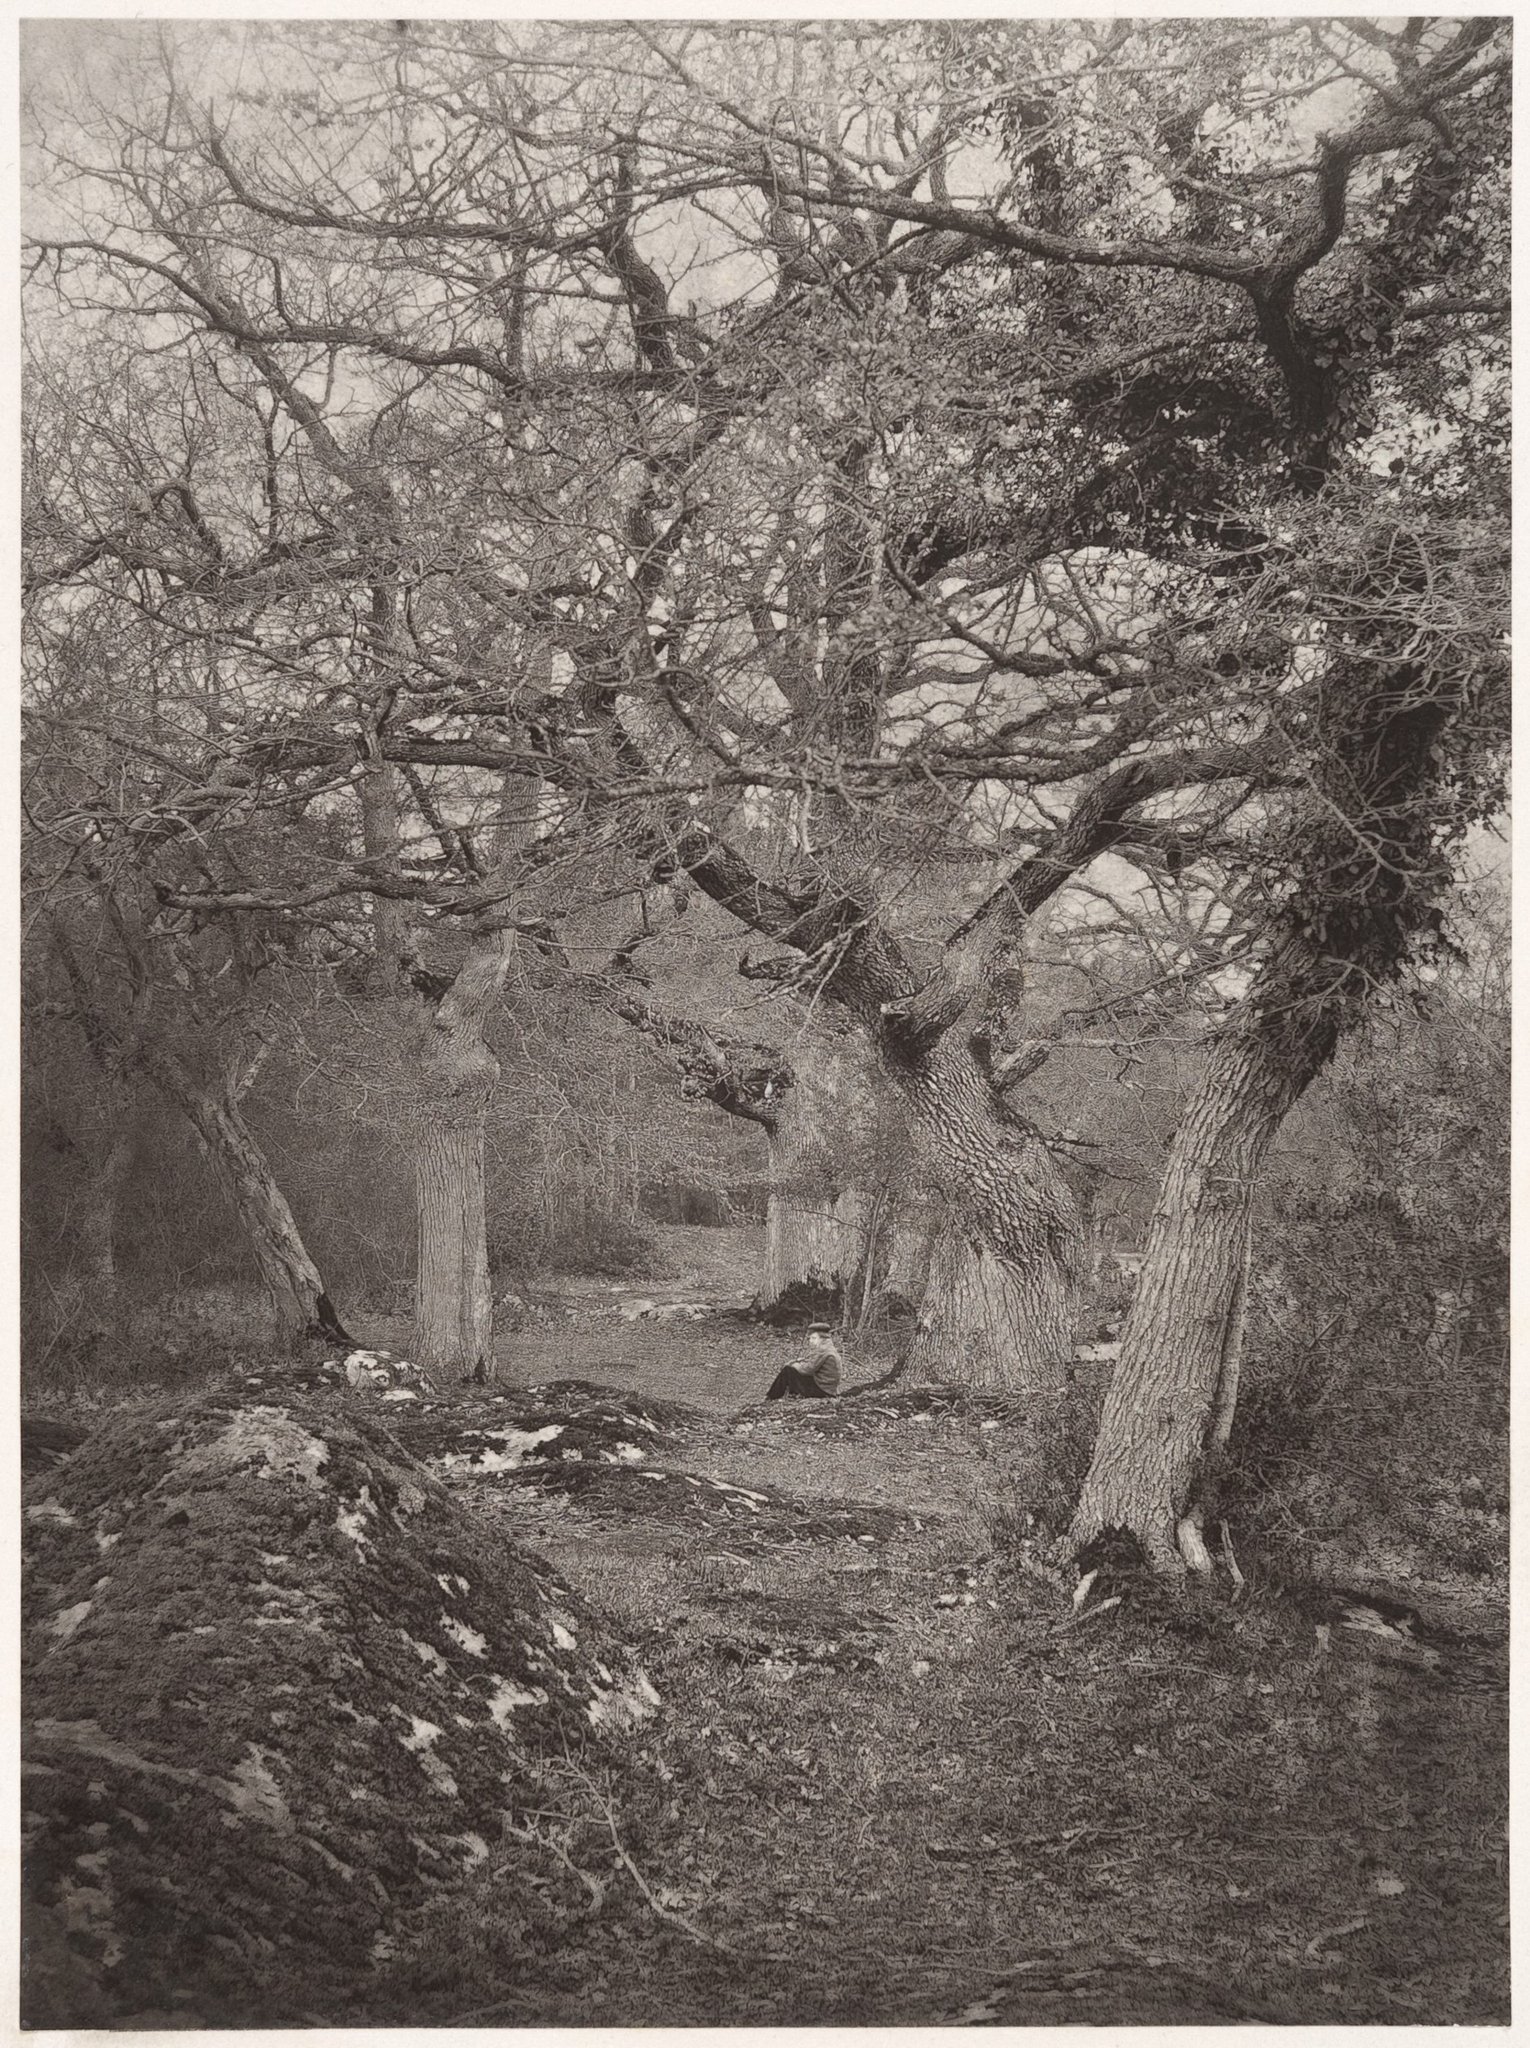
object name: photograph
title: Forêt de Fontainebleau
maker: william harrison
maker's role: artist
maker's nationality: british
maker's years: 1830-1900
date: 1870-1879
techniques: carbon print, glass negative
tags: forests,landscapes,trees